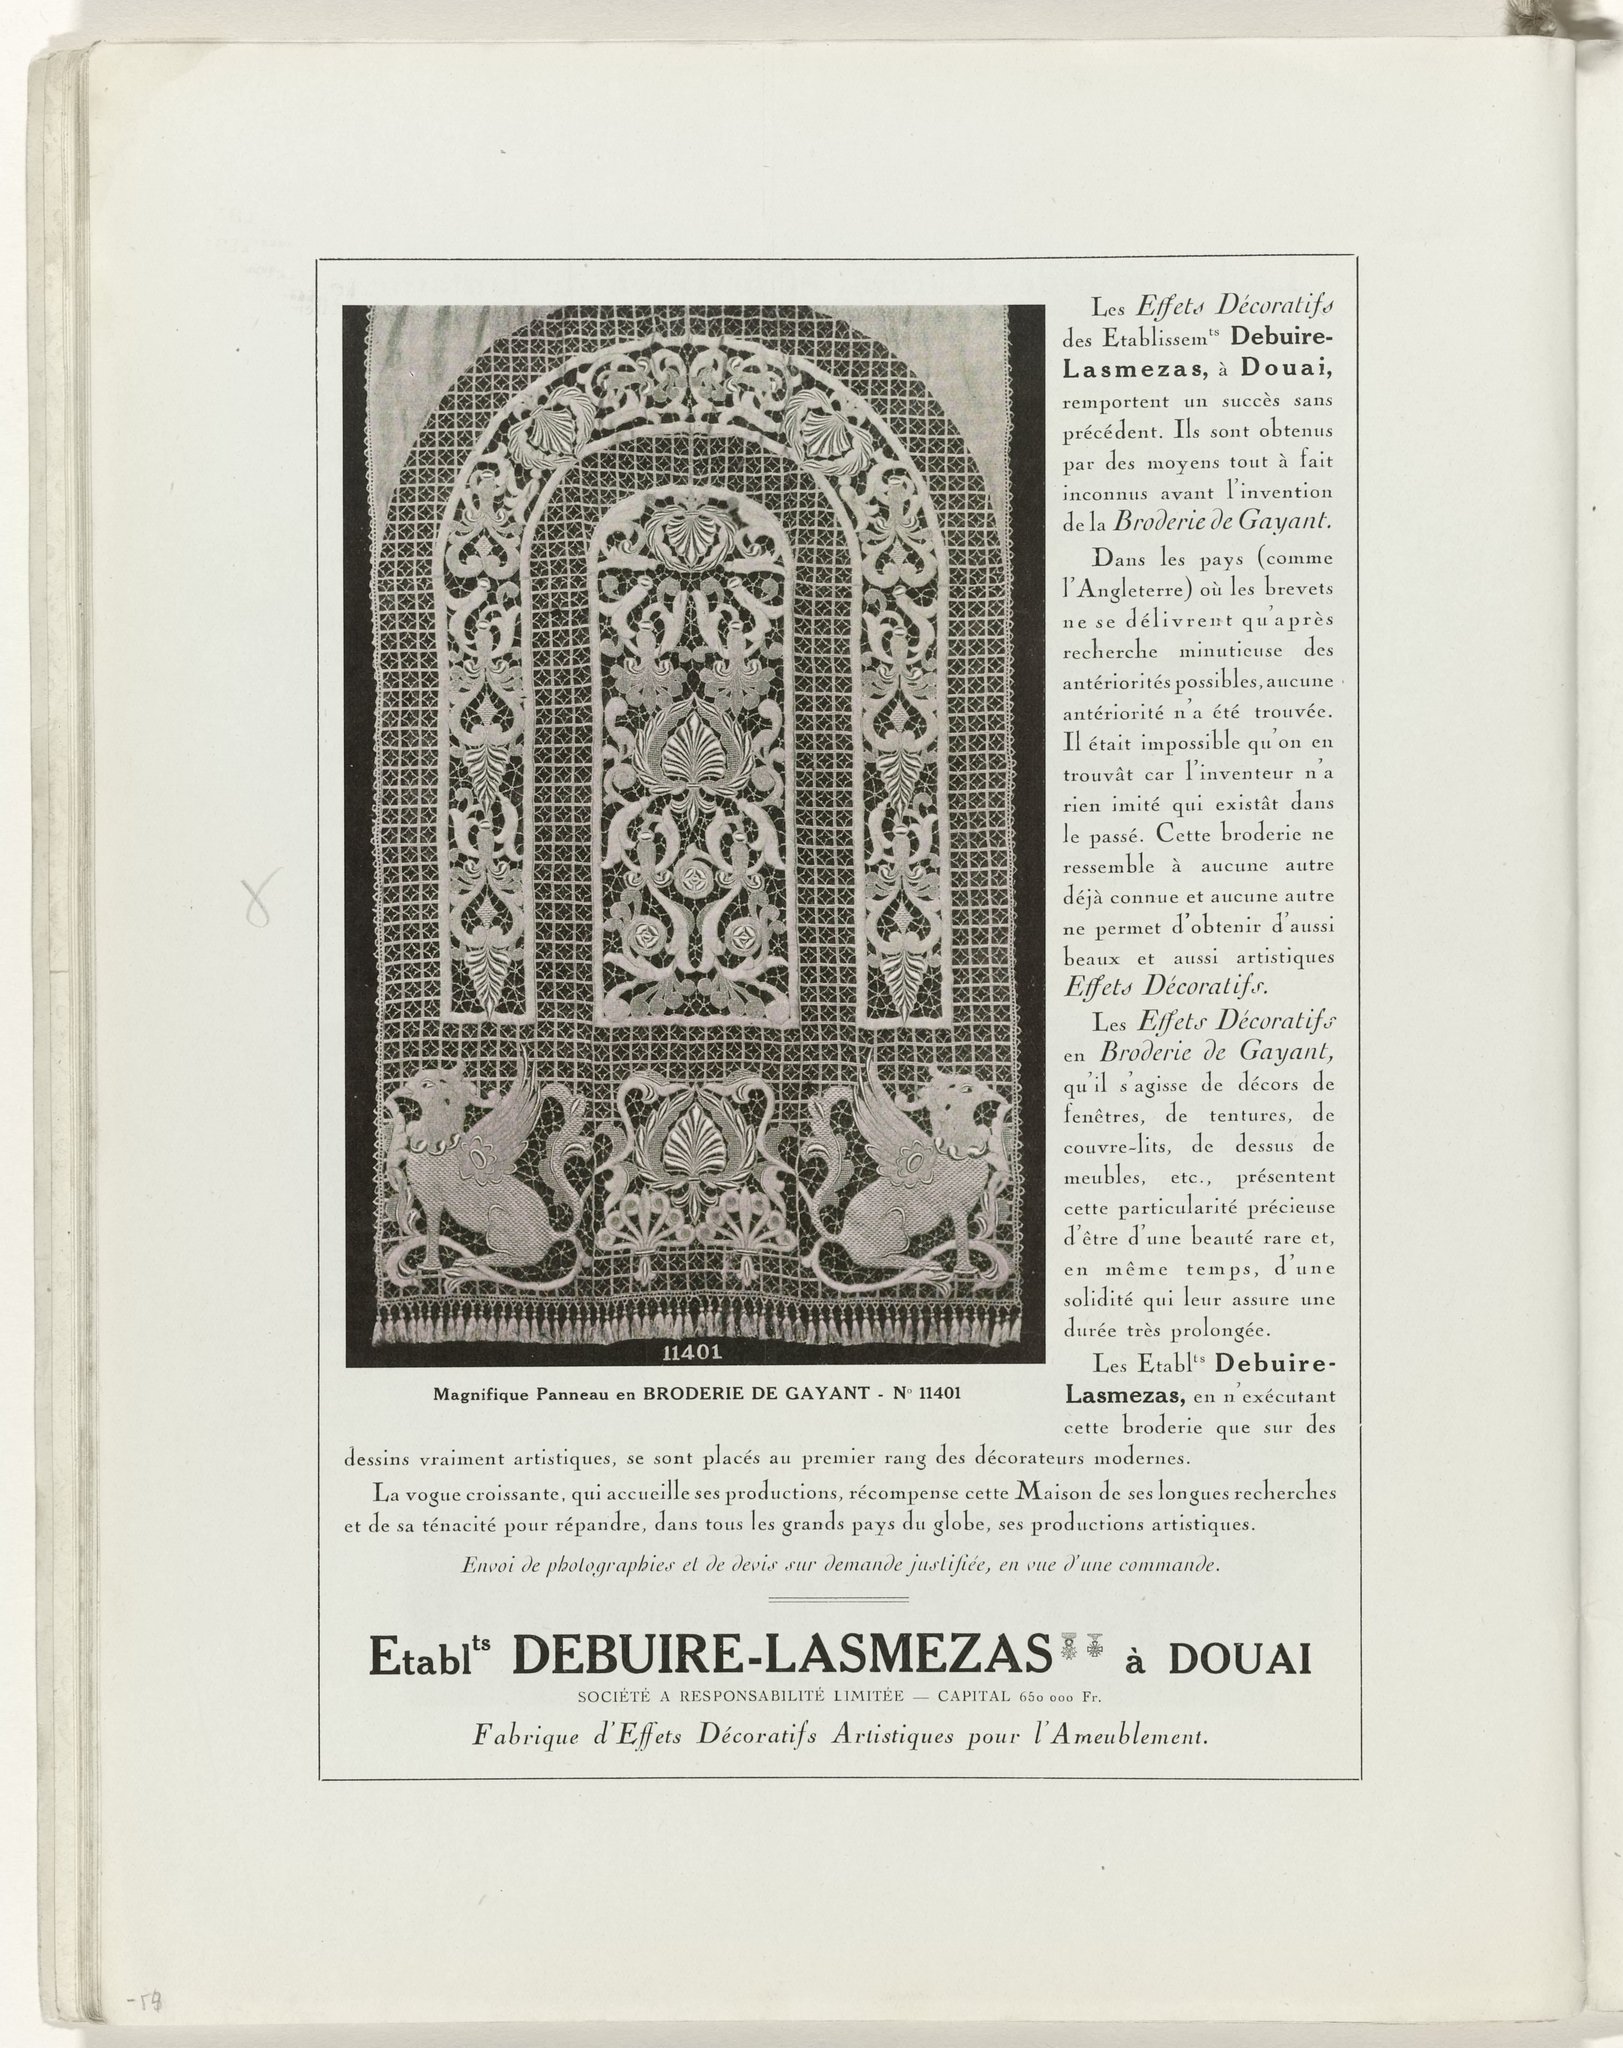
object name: fashion print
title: Art - Goût - Beauté, Feuillets de l' élégance féminine, Noël 1928, No. 100, 9e Année, p. 54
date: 1928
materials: paper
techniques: lithograph, photography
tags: embroidery (ornamentation) (+ women's clothes), fashion plates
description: Advertentietekst met afbeelding van een paneel van 'broderie de Gayant', van Debuire-Lasmezas. Pagina uit het modetijdschrift Art-Goût-Beauté (1920-1933).